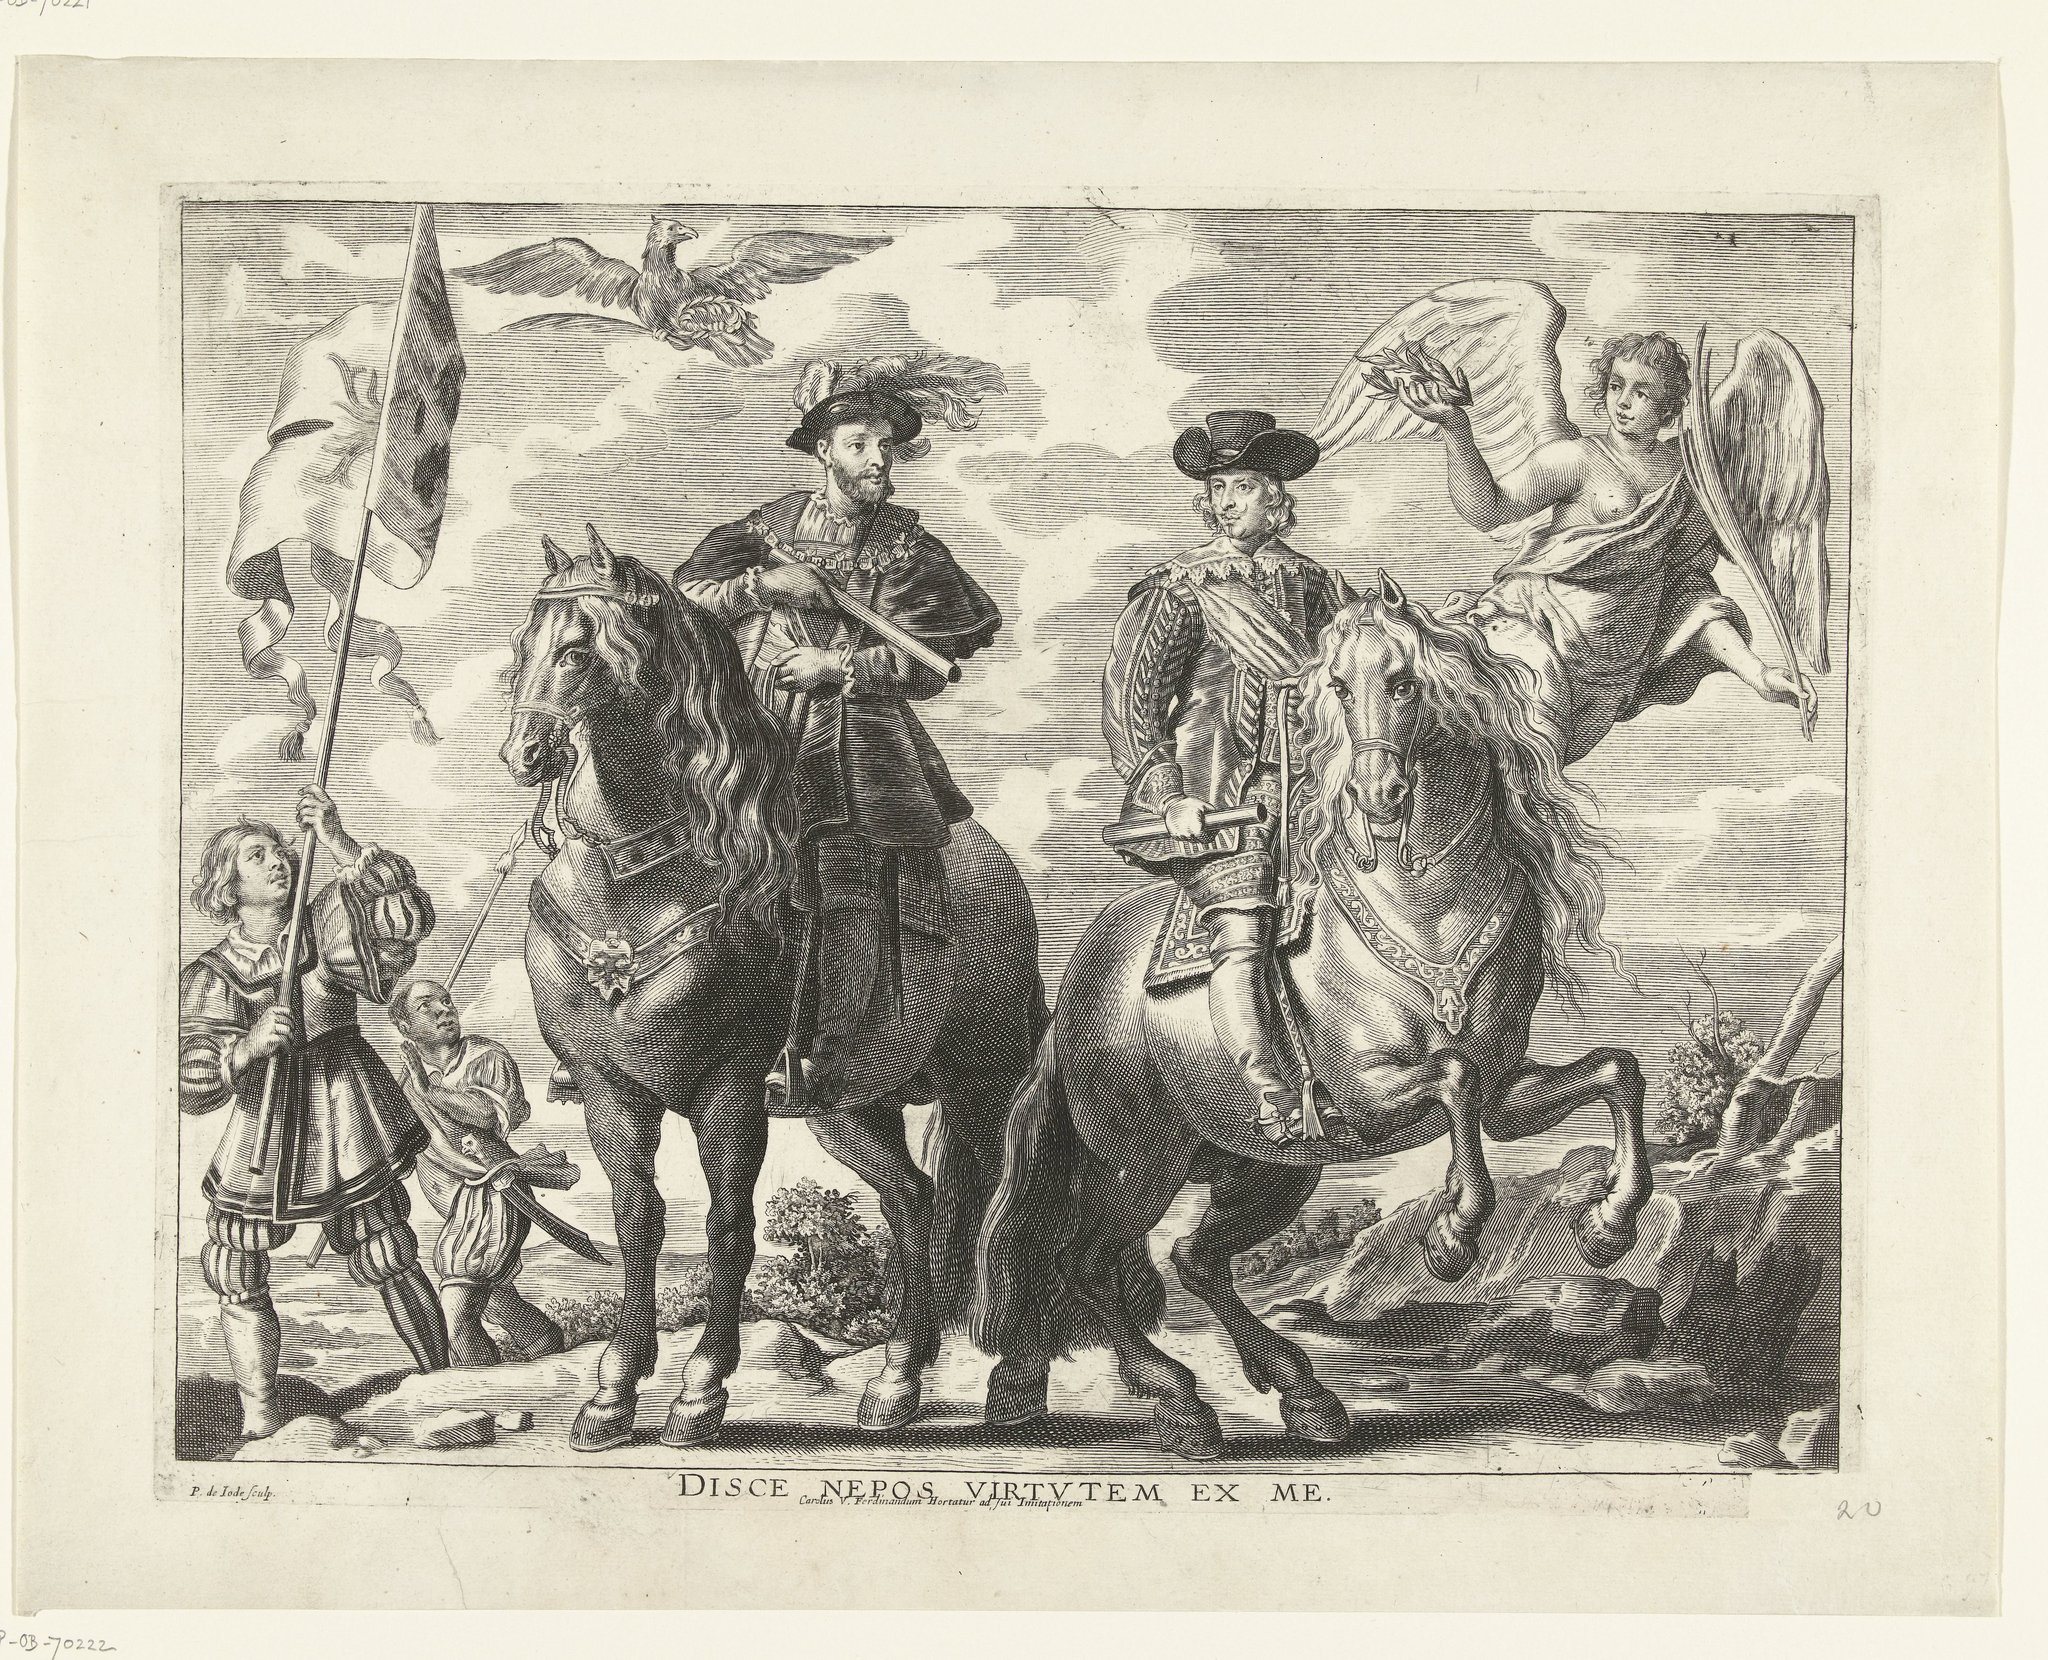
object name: print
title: Tabila I. Carolus Ferdinandum hortatur ad sui imitationem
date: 1635-1636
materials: paper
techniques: engraving, etching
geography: southern netherlands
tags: ghent, charles v (holy roman emperor and king of spain), brussels, landvoogd der zuidelijke nederlanden ferdinand van oostenrijk, triumphal arch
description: Karel V en Ferdinand te paard. Karel spoort Ferdinand aan zijn voorbeeld te volgen. Voorstelling middenboven op de voorzijde van de triomfpoort Arcus Caroli op de Vrijdagmarkt. Blad nr. 20 in een geheel van 42 platen die de uitgave van de beschrijving van de intocht van de Kardinaal Infant Ferdinand van Oostenrijk te Gent op 28 januari 1635 als de nieuwe landvoogd voor de Spaanse Nederlanden illustreren.